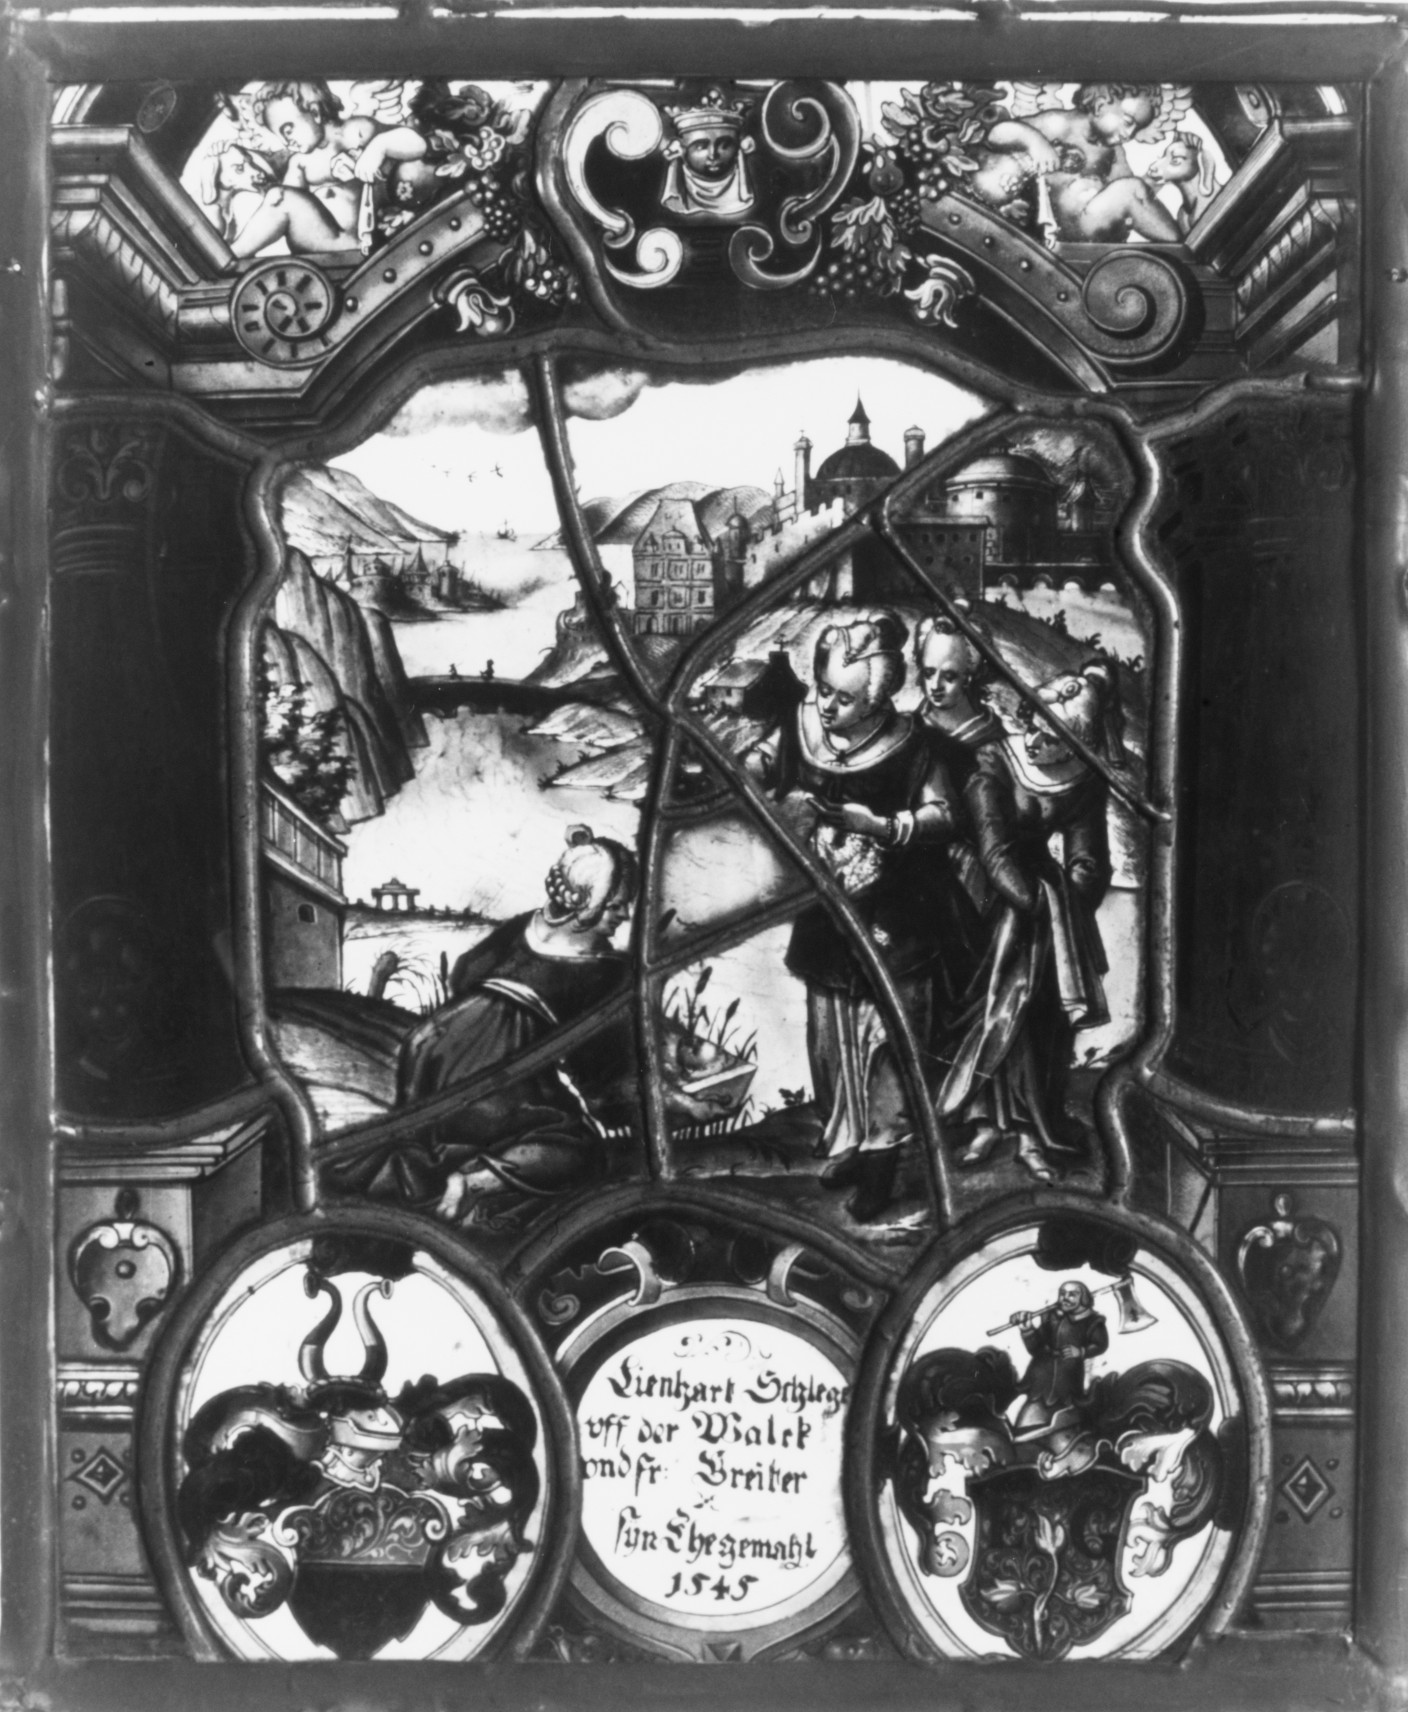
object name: panel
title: The Finding of Moses by Pharaoh's Daughter (one of a pair)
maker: st. gallen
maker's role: maker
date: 1545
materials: glass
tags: animals,men,women,coat of arms